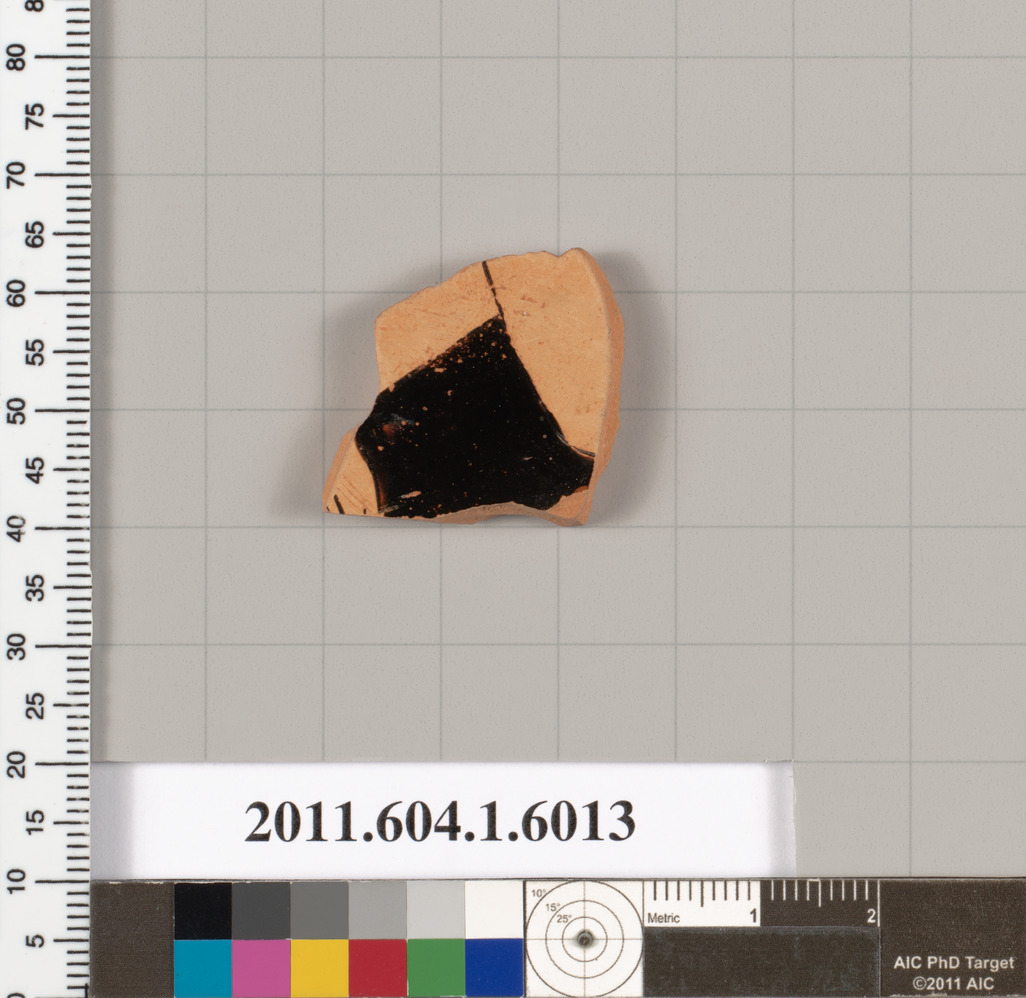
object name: kylix fragment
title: Terracotta fragment of a kylix (drinking cup)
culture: greek, attic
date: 510-500 BCE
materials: terracotta